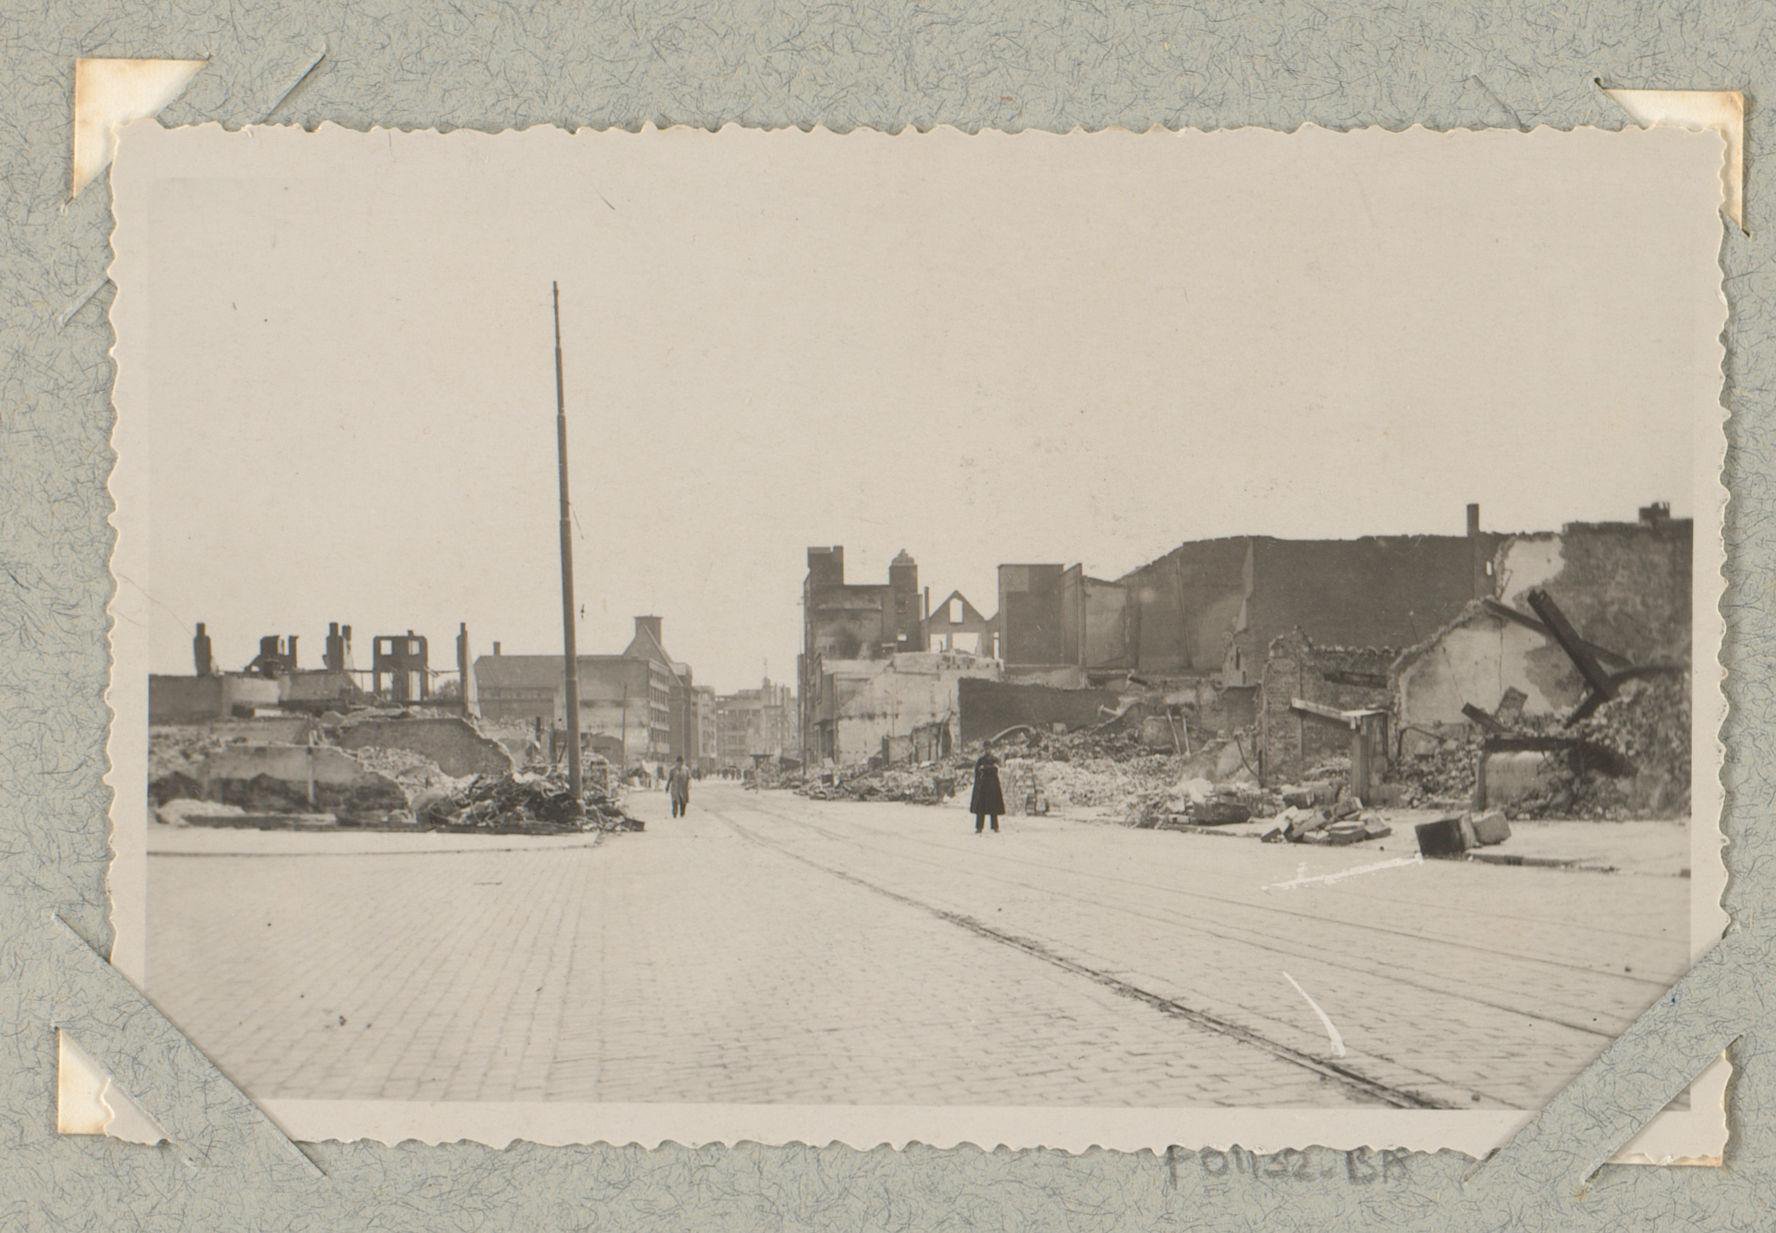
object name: ansichtkaart, prentbriefkaart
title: Gezicht op ruïnes van gebouwen aan de Botersloot te Rotterdam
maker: j. nolte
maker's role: fotograaf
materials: photographic support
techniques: photography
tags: devastated, ruined place or city (~ warfare), street, ruin of a dwelling, house, castle, etc., rotterdam, rotterdam blitz